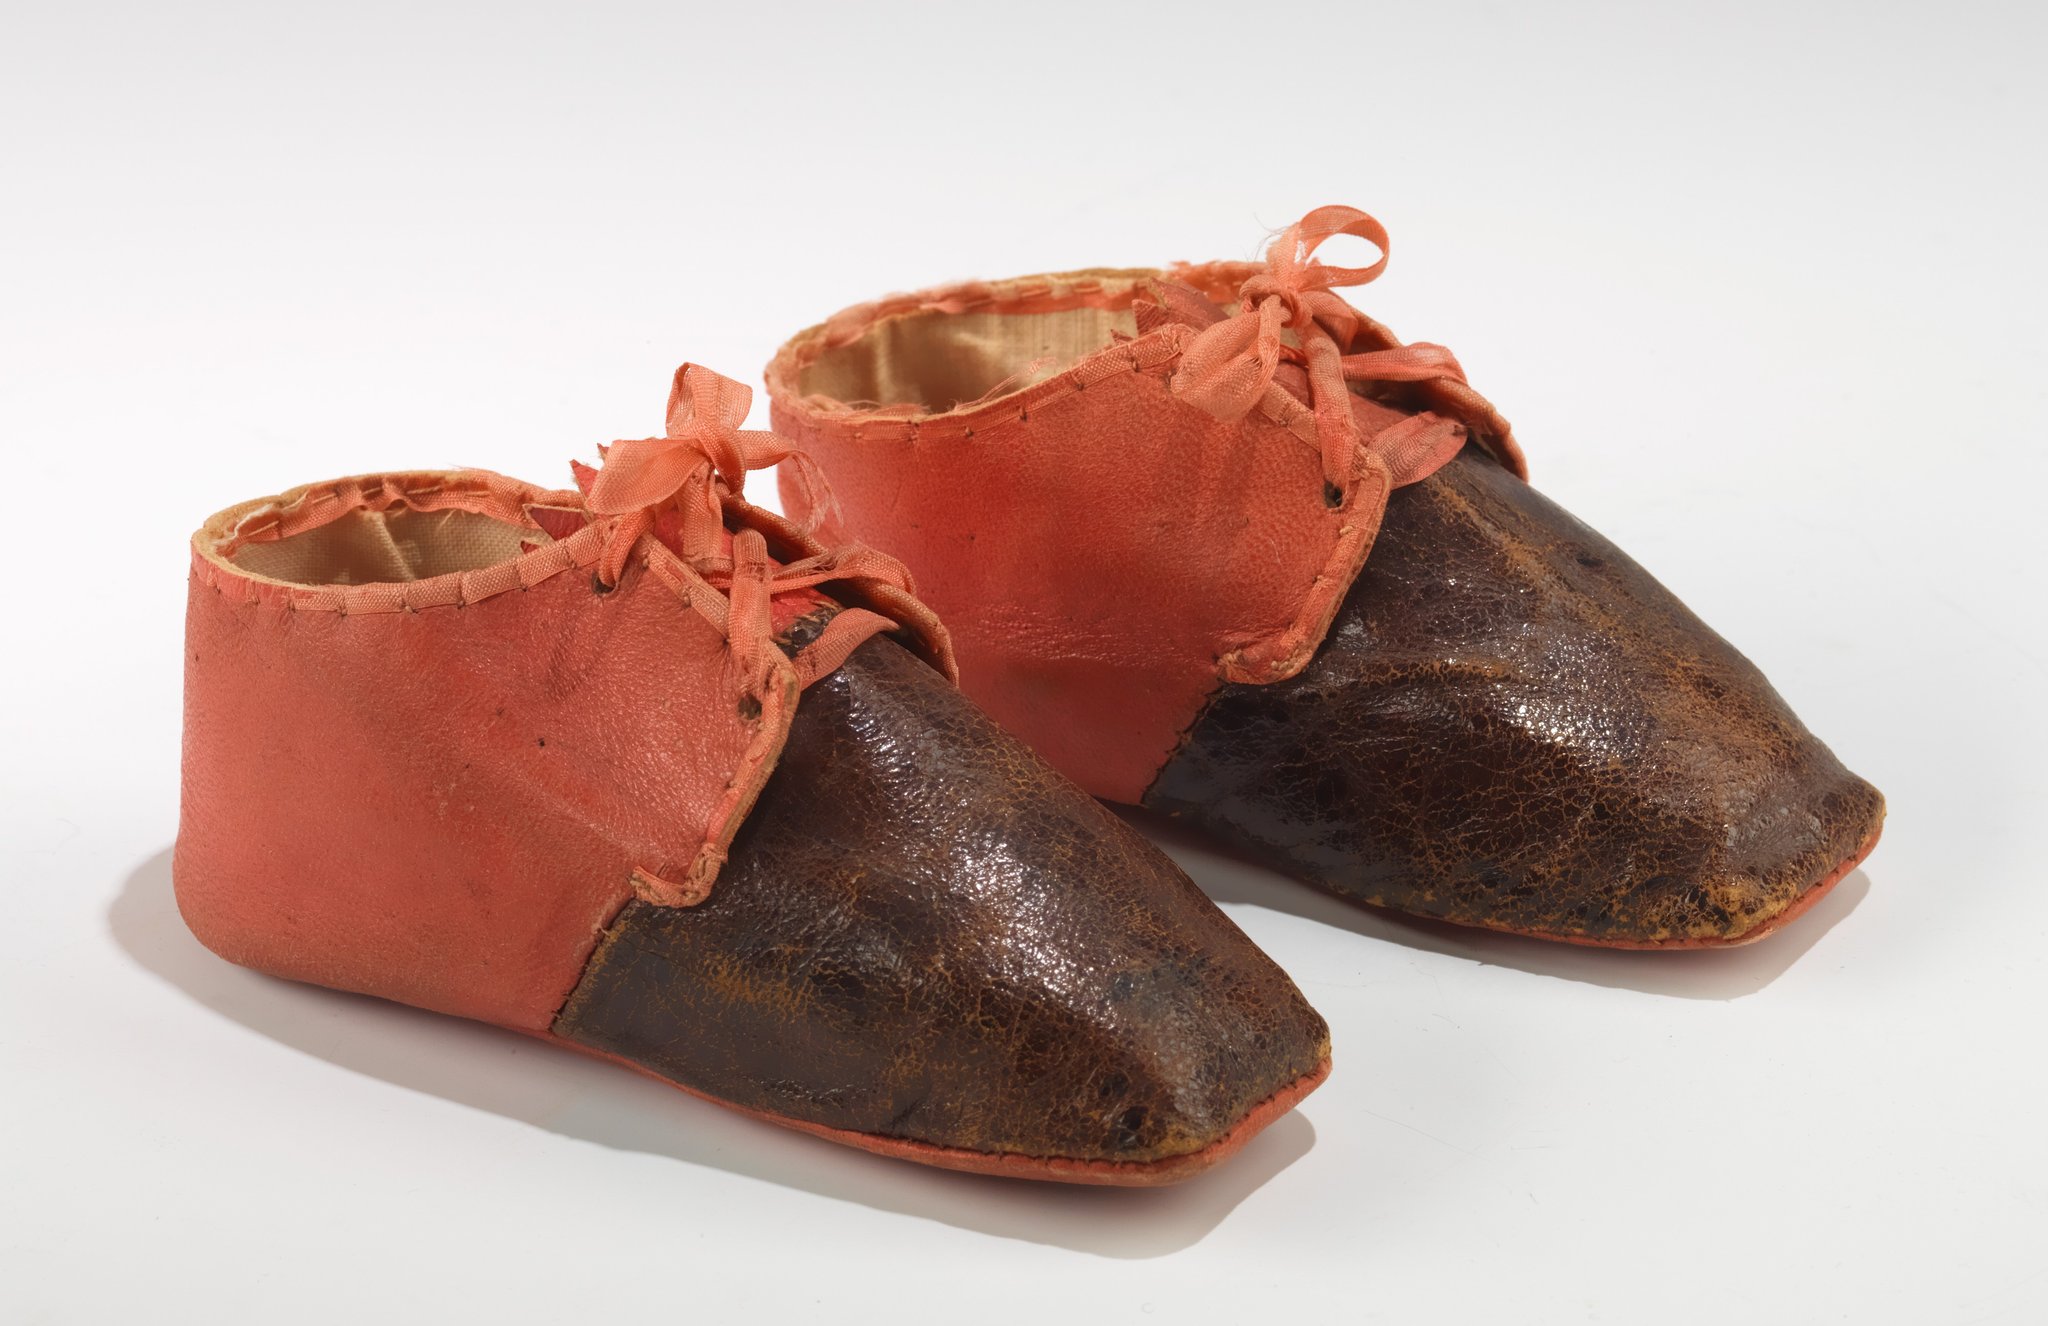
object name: shoe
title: Shoes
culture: american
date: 1832-1833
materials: leather